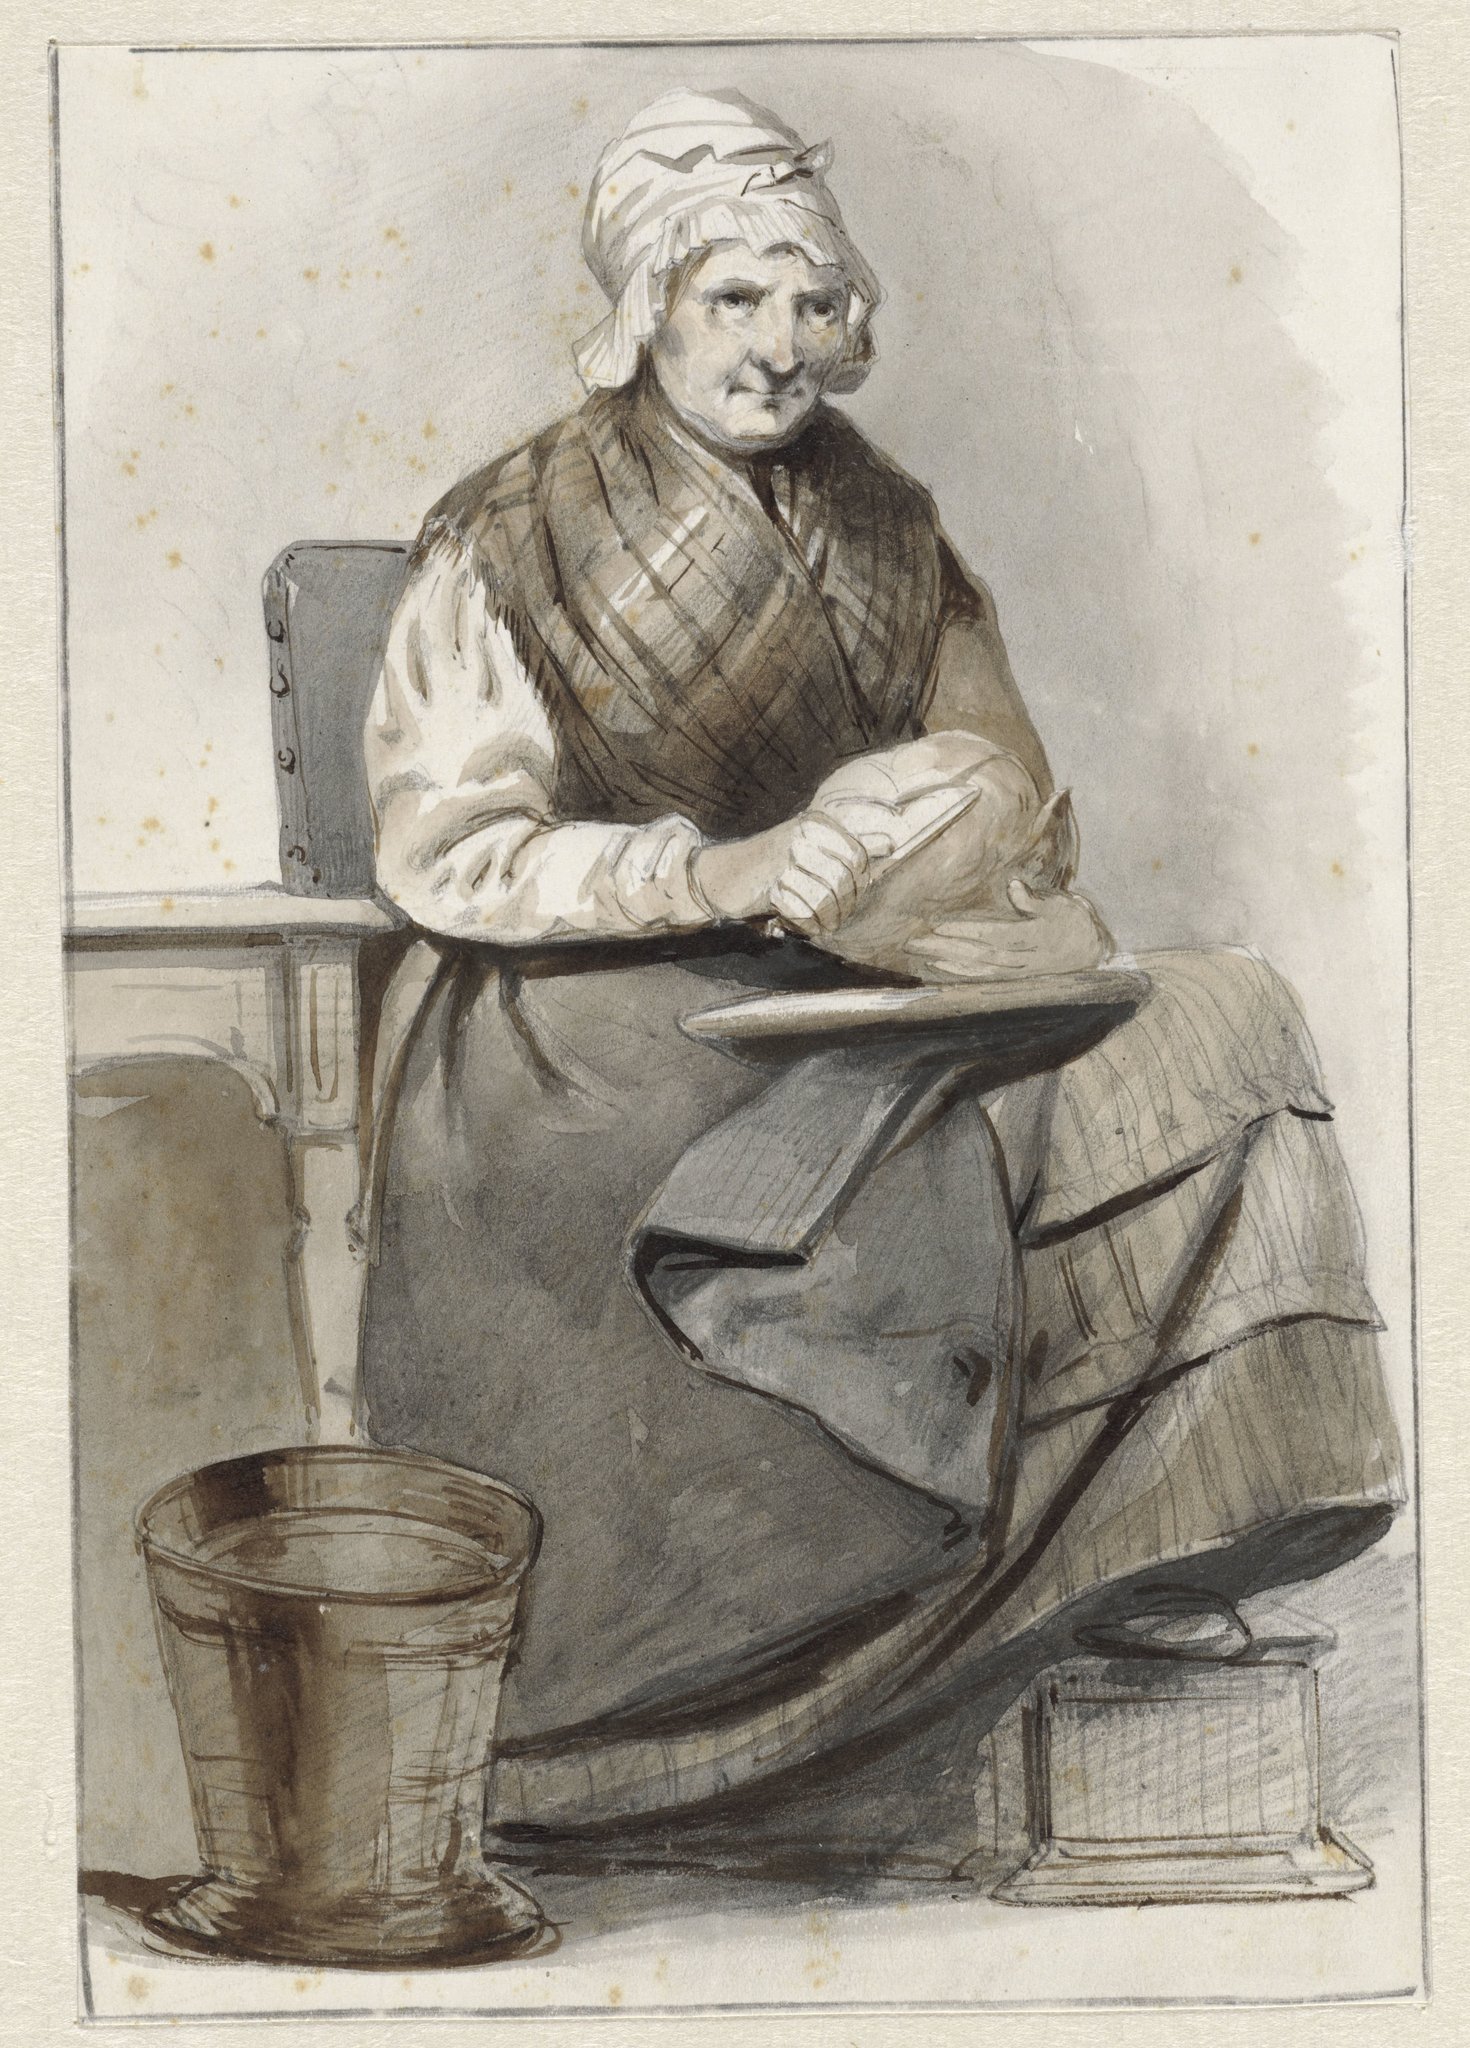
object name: drawing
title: Zittende vrouw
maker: pieter marinus van de laar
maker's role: draughtsman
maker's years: 1824-1862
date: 1834-1862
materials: ink, paper, pencil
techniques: brush, pen